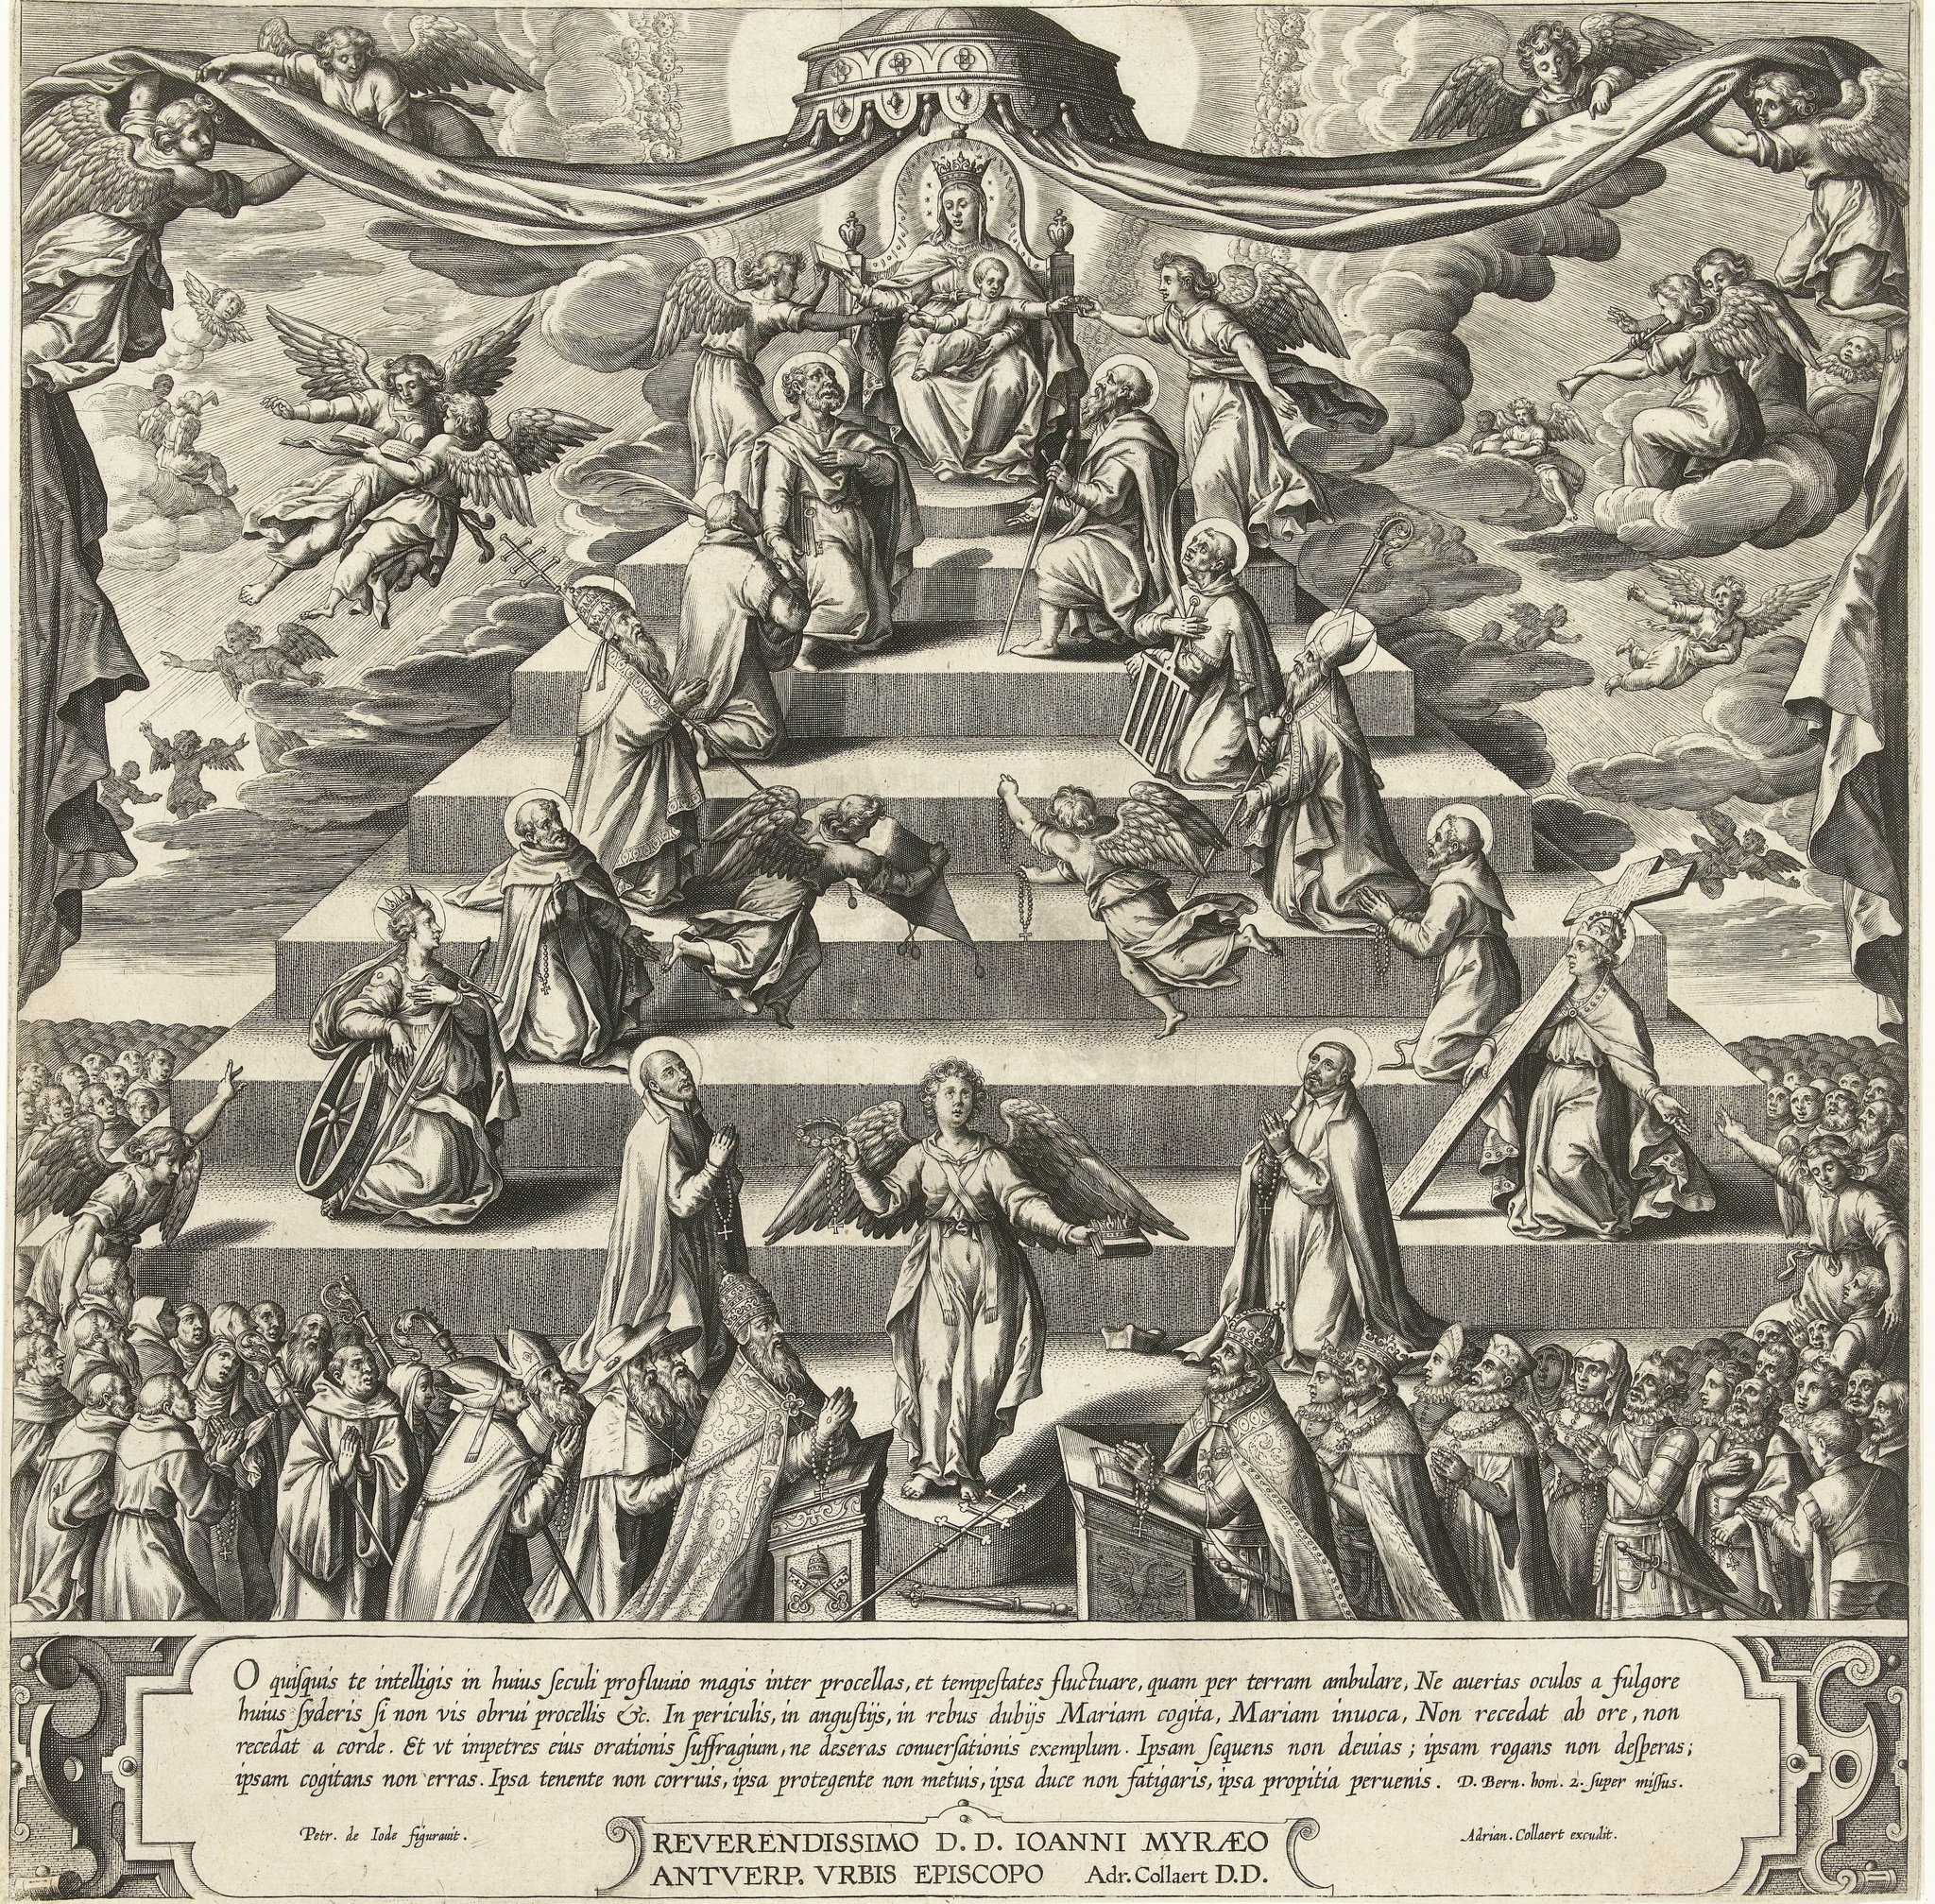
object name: print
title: Tronende Maria met kind en heiligen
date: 1603-1618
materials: paper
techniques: engraving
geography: antwerp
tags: mary enthroned (+ angel(s)), the martyr and deacon laurence of rome; possible attributes: book, censer, cross, dalmatic, gridiron, palm, purse (or cup with golden coins) (+ mary), the virgin martyr catherine of alexandria; possible attributes: book, crown, emperor maxentius, palm-branch, ring, sword, wheel (+ mary), the apostle peter, first bishop of rome; possible attributes: book, cock, (upturned) cross, (triple) crozier, fish, key, scroll, ship, tiara (+ mary), the apostle paul of tarsus; possible attributes: book, scroll, sword (+ mary), ladder, stairway to heaven, mary enthroned (+ donor(s), supplicant(s), whether or not with patron saint(s))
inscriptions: number: ‘20447’, collector's mark: Lugt 2228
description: Een trapgewijze opstelling met bovenaan de tronende Maria met kind. Engelen houden een baldakijn boven hun hoofd. De trap bestaat uit zes treden, met op elke trede twee heiligen (ondere andere de Heilige Petrus, de Heilige Paulus, de Heilige Catharina van Alexandrië en de Heilige Laurentius. Onderaan links de geestelijke macht (met paus, bisschoppen, kardinalen en monniken). Onderaan rechts de wereldlijke macht (met koningen en edelen) en het volk. De prent heeft een cartouche met Latijns onderschrift.